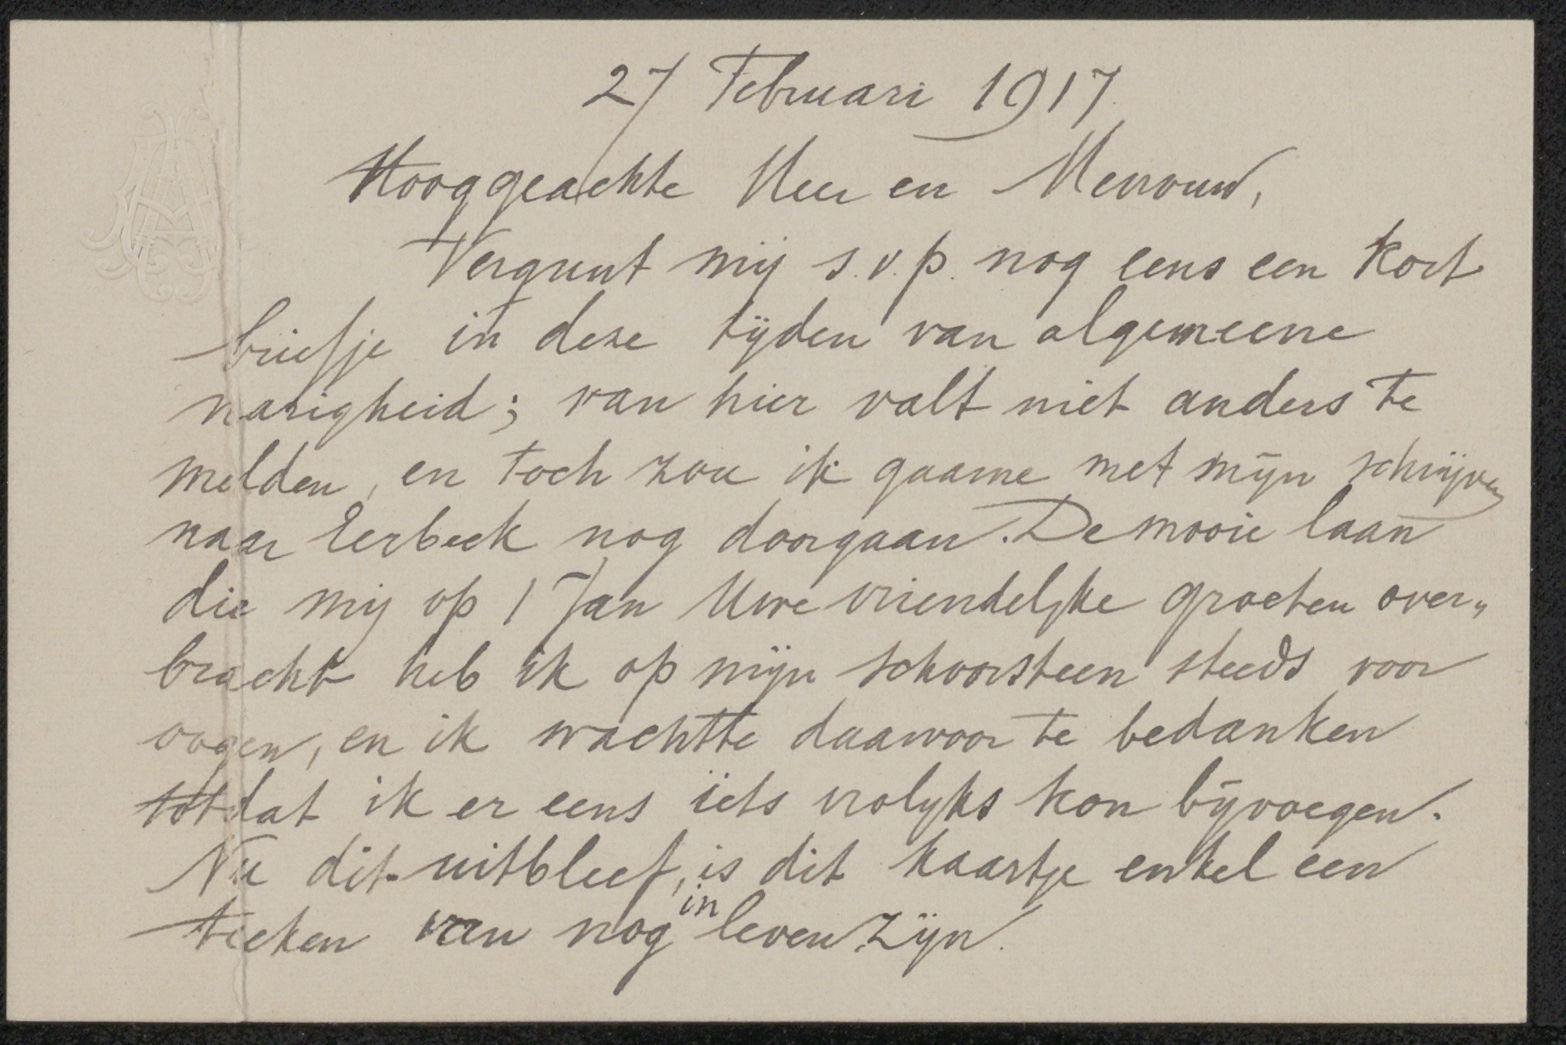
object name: letter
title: Brief aan Max Wilhelm Carl Weber en Anne Antoinette Weber-Van Bosse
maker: august allebé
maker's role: draughtsman, print maker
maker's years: 1838-1927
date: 1917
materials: cardboard, ink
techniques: pen, writing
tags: amsterdam, anne antoinette weber-van bosse, photography, cinematography, diseases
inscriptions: monogram: ‘AA’